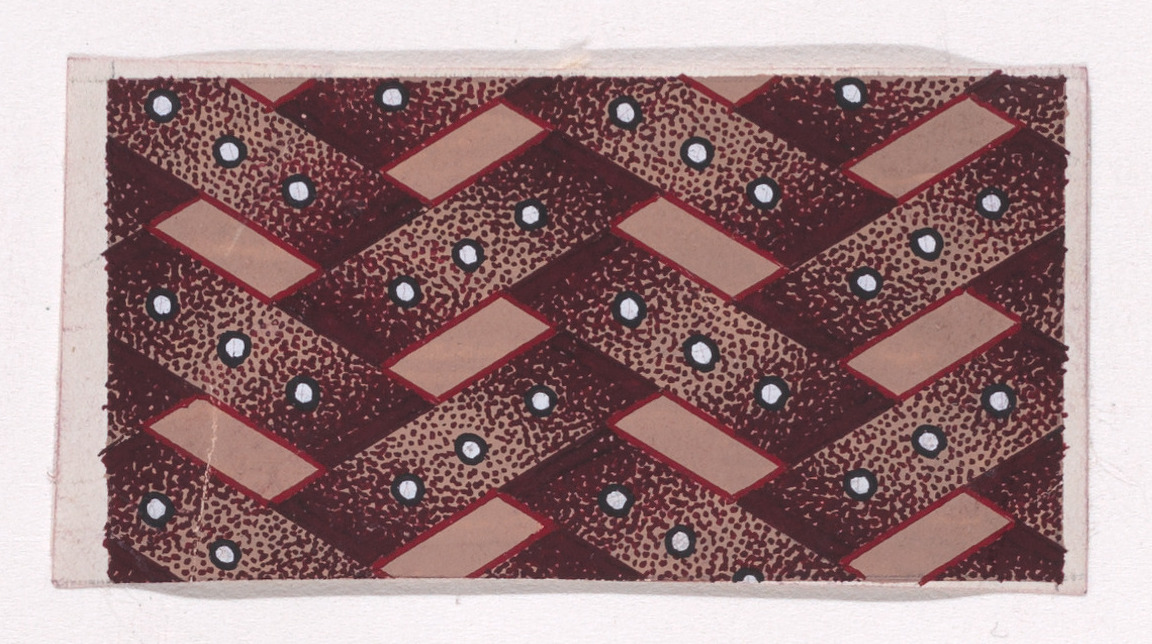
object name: drawing ornament architecture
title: Textile Design with a Basketweave Pattern Decorated with Pearls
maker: anonymous, alsatian, 19th century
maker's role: artist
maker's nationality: alsatian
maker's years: 1800-1900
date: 1840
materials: gouache